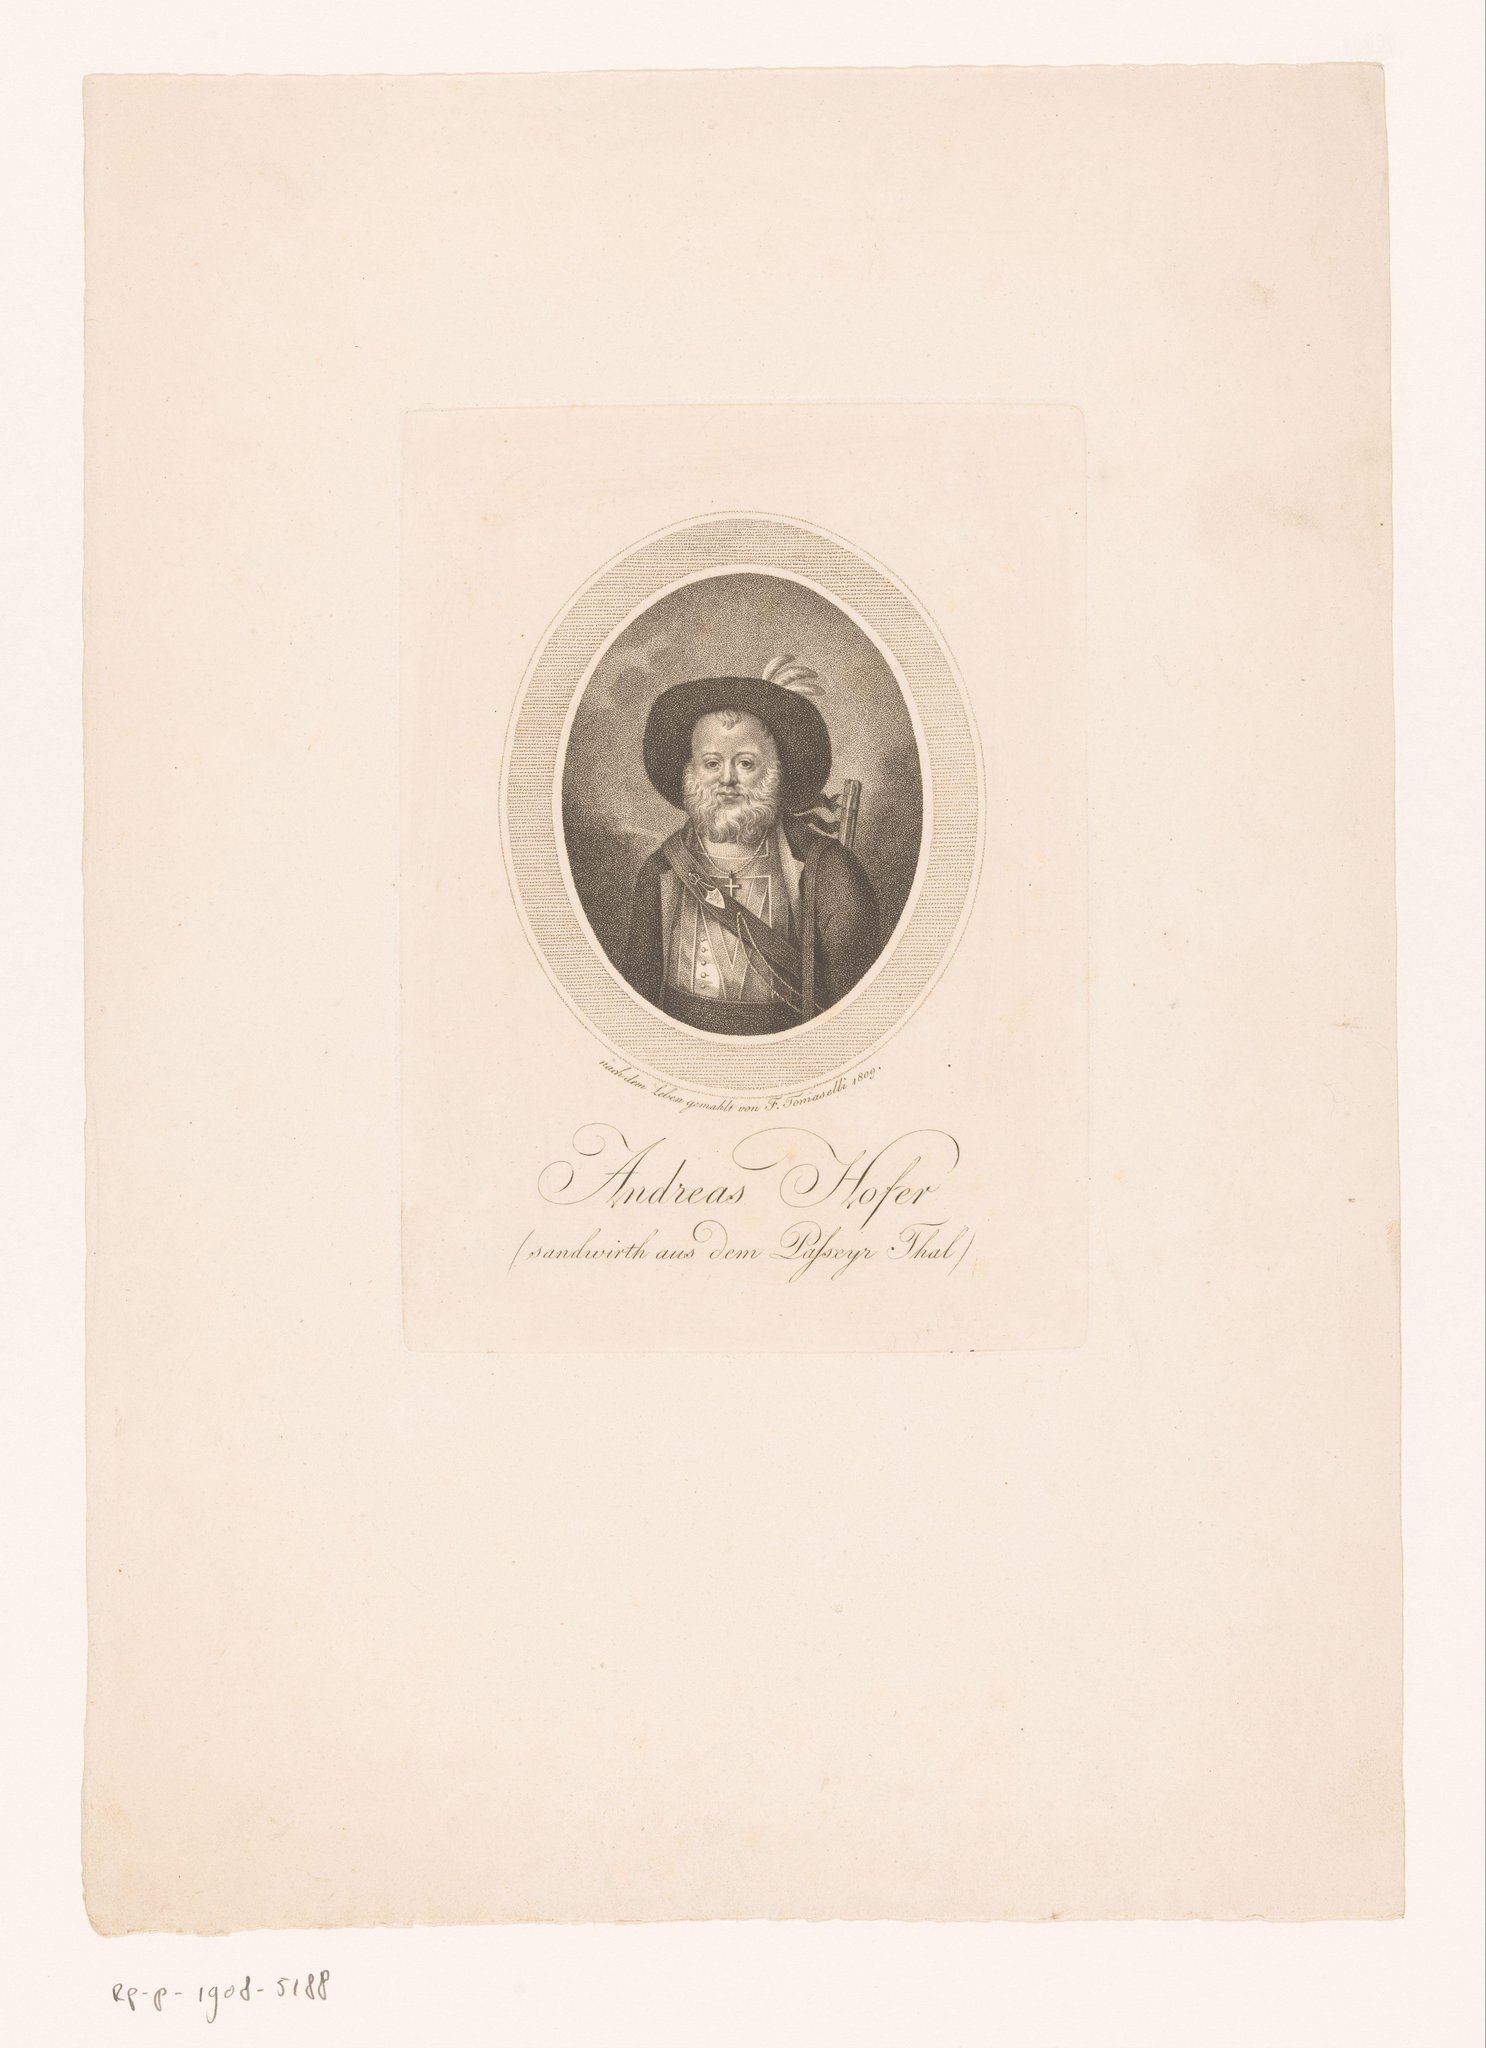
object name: print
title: Portret van Andreas Hofer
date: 1809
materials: paper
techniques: engraving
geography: germany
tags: historical persons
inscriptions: collector's mark: Lugt 2228